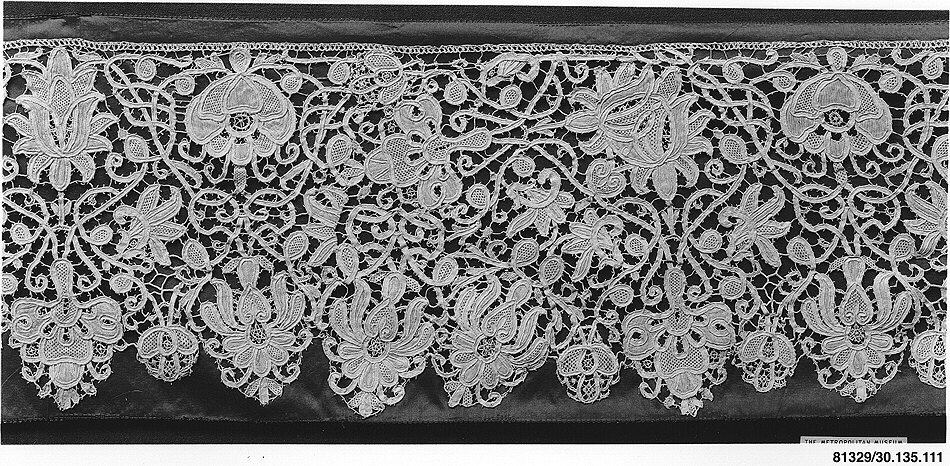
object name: border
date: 1501-1700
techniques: lace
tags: flowers